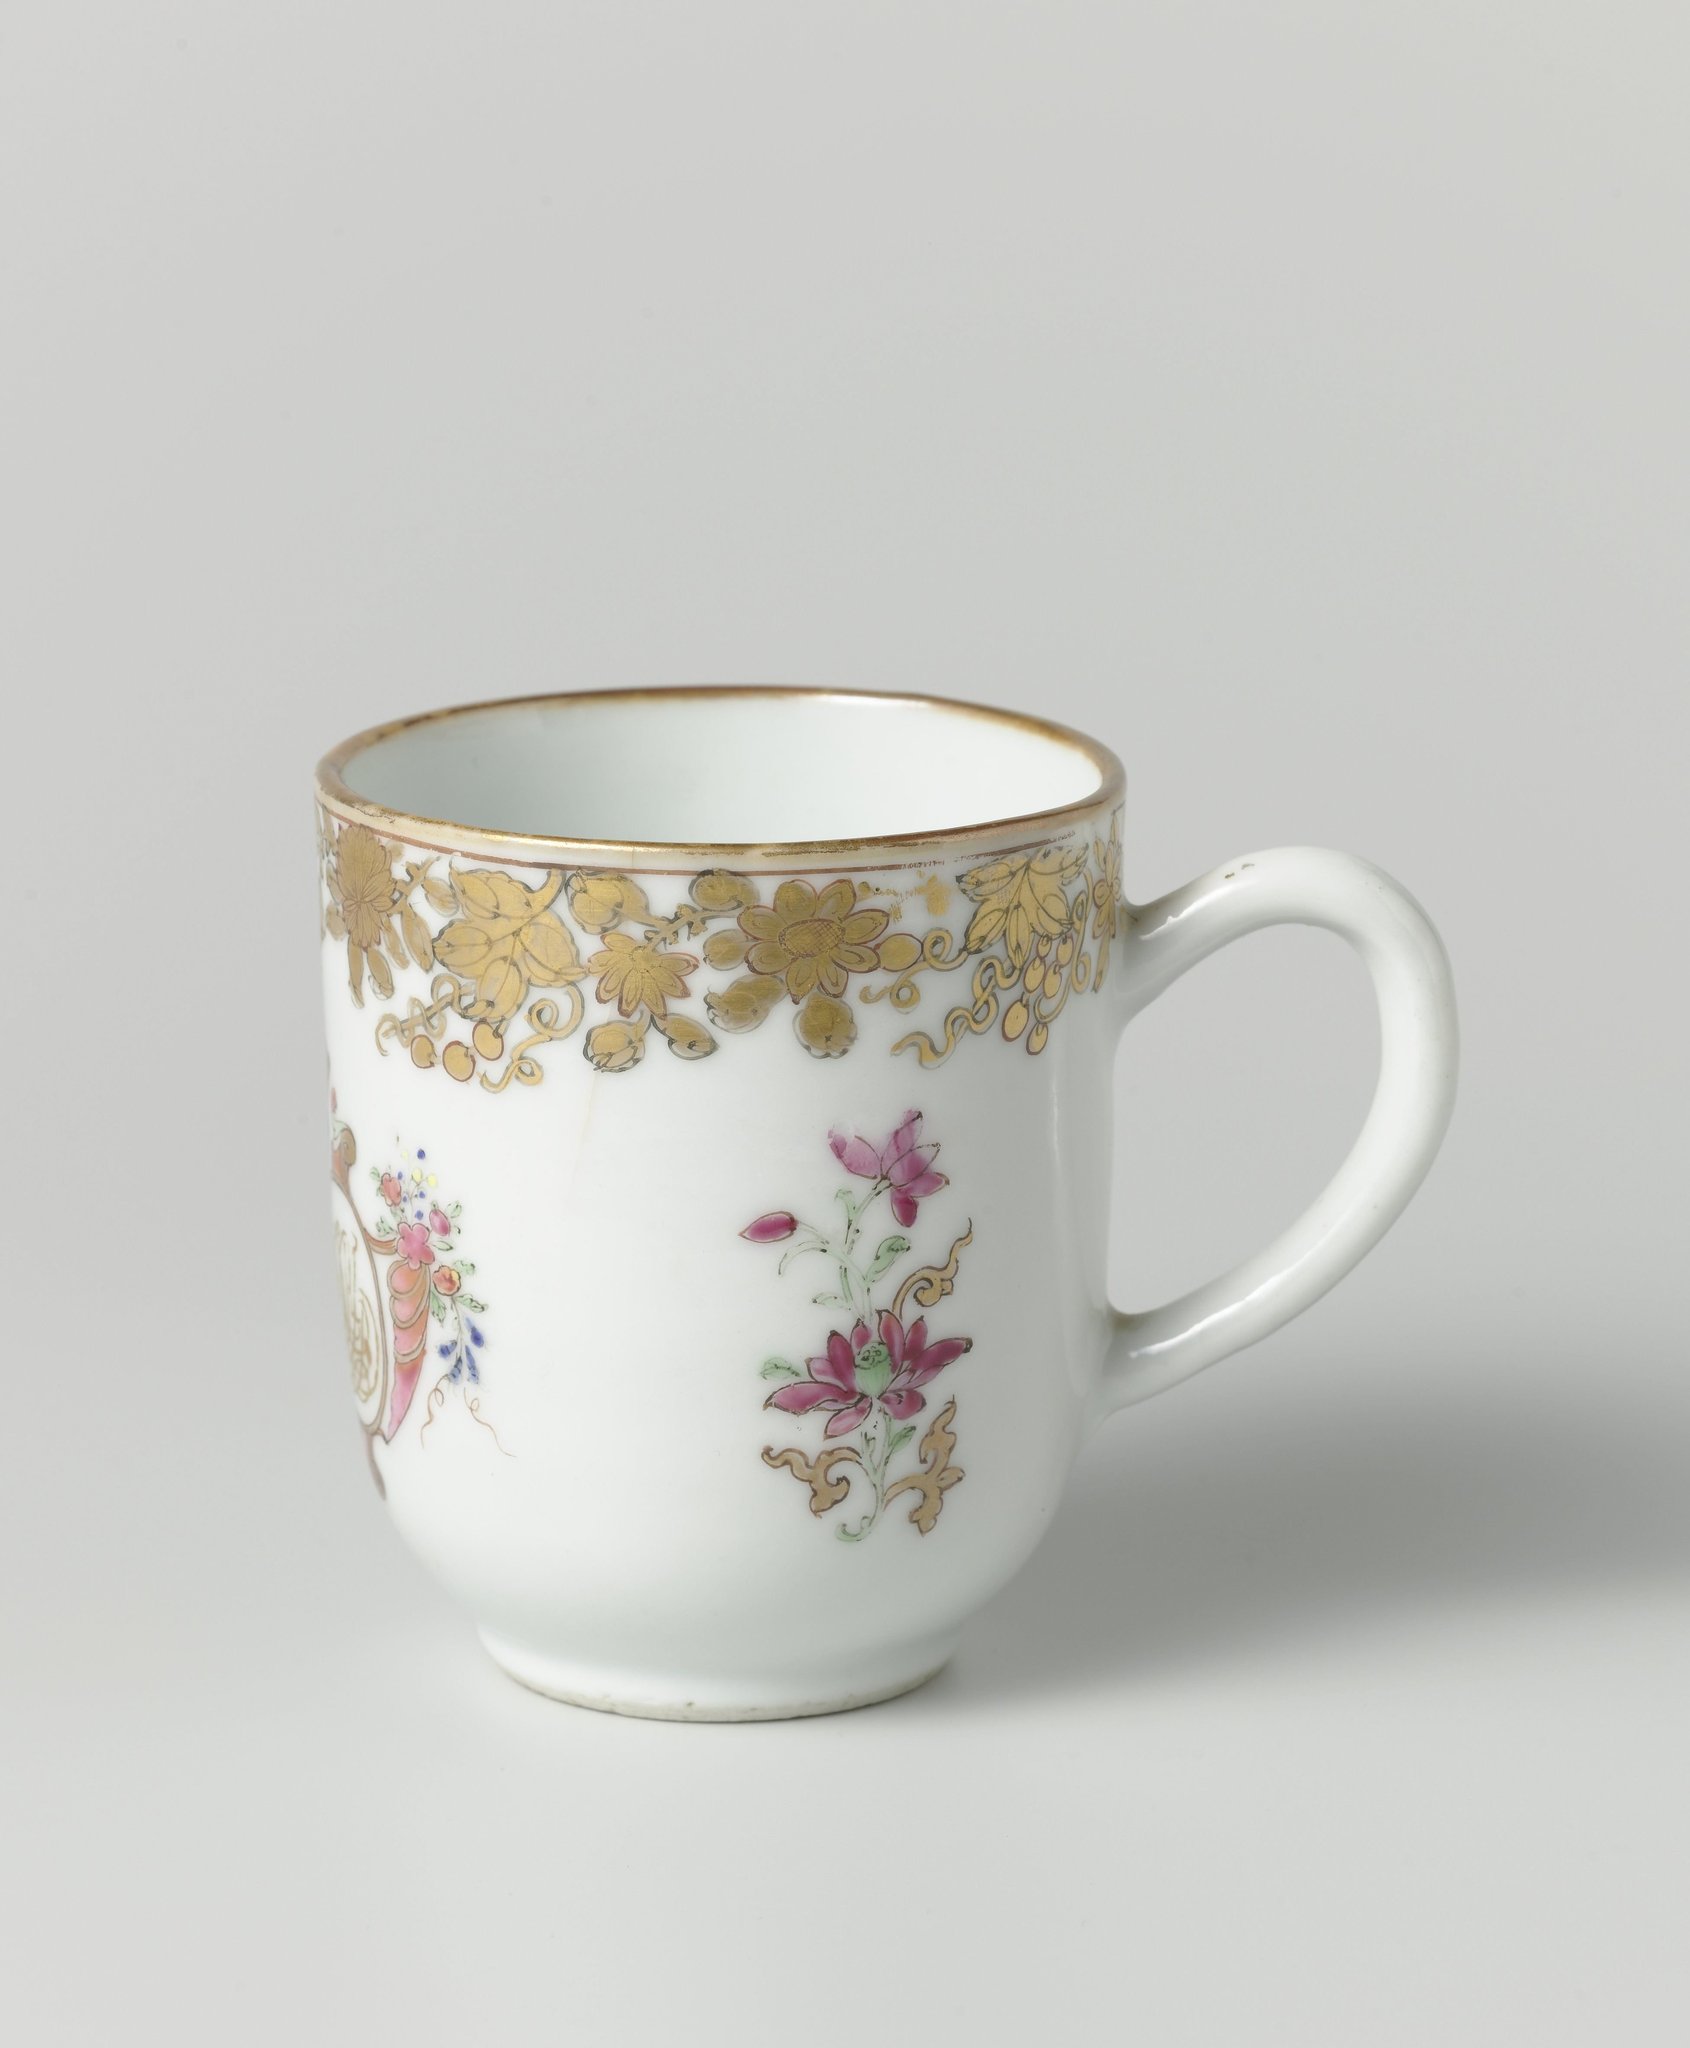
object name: oorkop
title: Cup with handle from the 'Swellengrebel service' with a double crowned monogram and a border with floral scrolls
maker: Anonymous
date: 1740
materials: glaze, gold, paint, porcelain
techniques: firing, gilding, turning, vitrification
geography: china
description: De monogrammen 'MVA' en 'CHTD' staan voor Maurits van Aerden (1694-1746) en Constantia Helena ten Damme (1694-1772), getrouwd in 1716. Het servies is waarschijnlijk besteld ter ere van hun vijfentwingtigjarig huwelijksjubileum in 1741. (Campen, Jan van & Hartkamp-Jonxis, Ebeltje, Aziatische weelde : VOC-kunst in het Rijksmuseum, Zutphen 2011, p. 78)